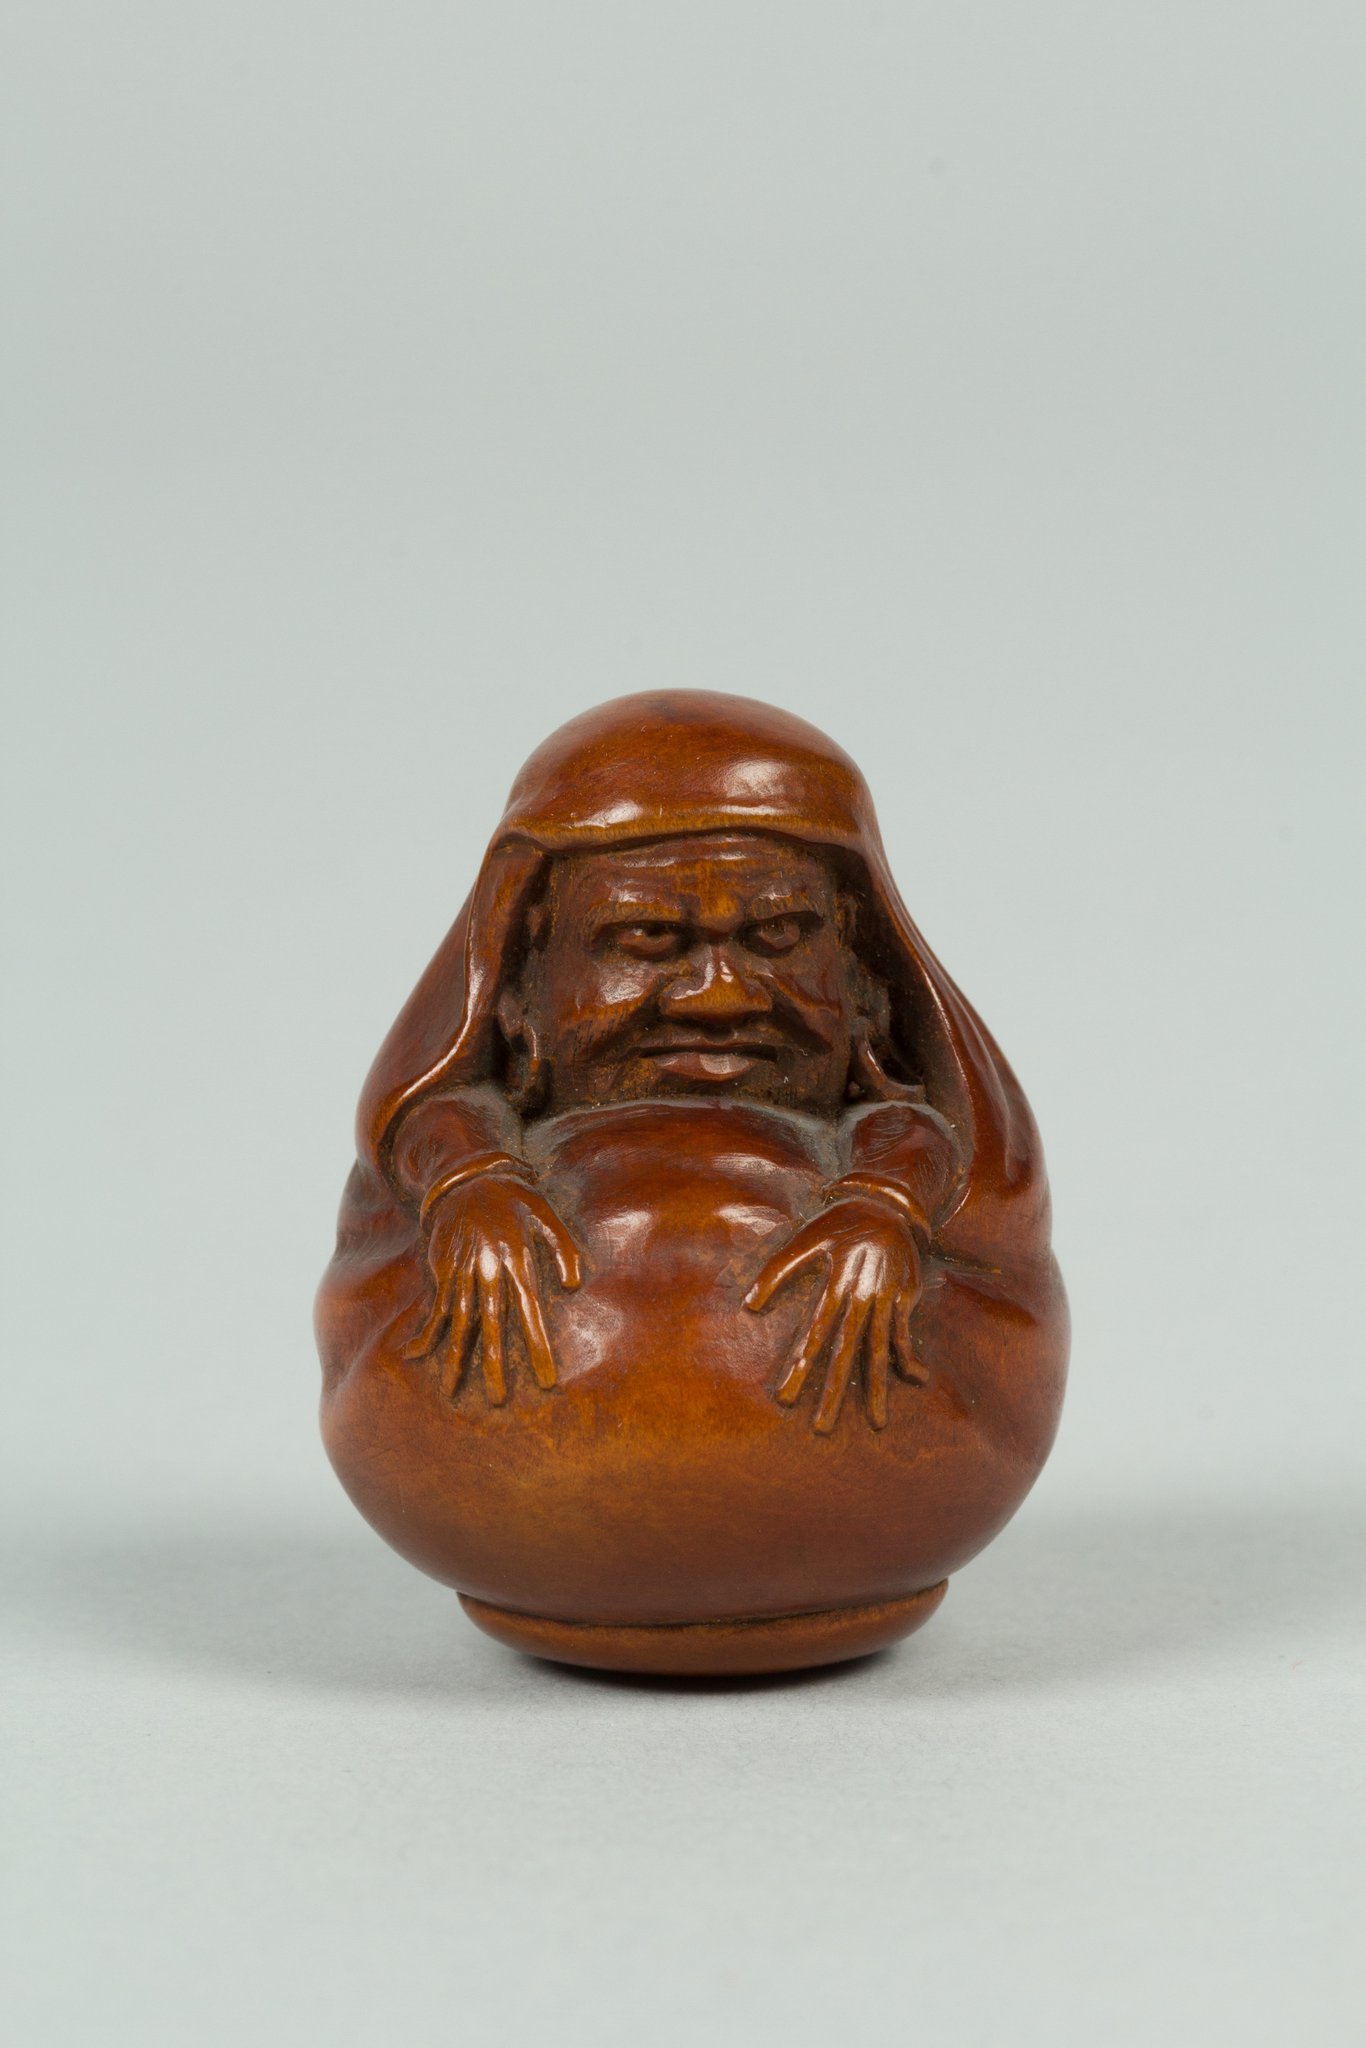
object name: netsuke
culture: japanese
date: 1801-1900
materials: wood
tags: human figures